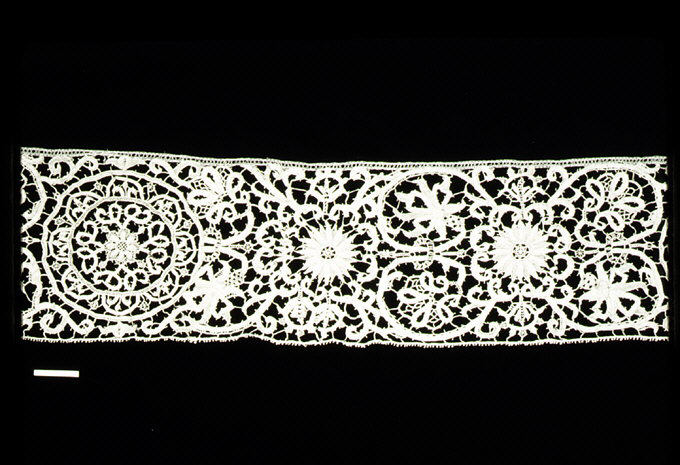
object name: border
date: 1601-1633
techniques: lace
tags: flowers